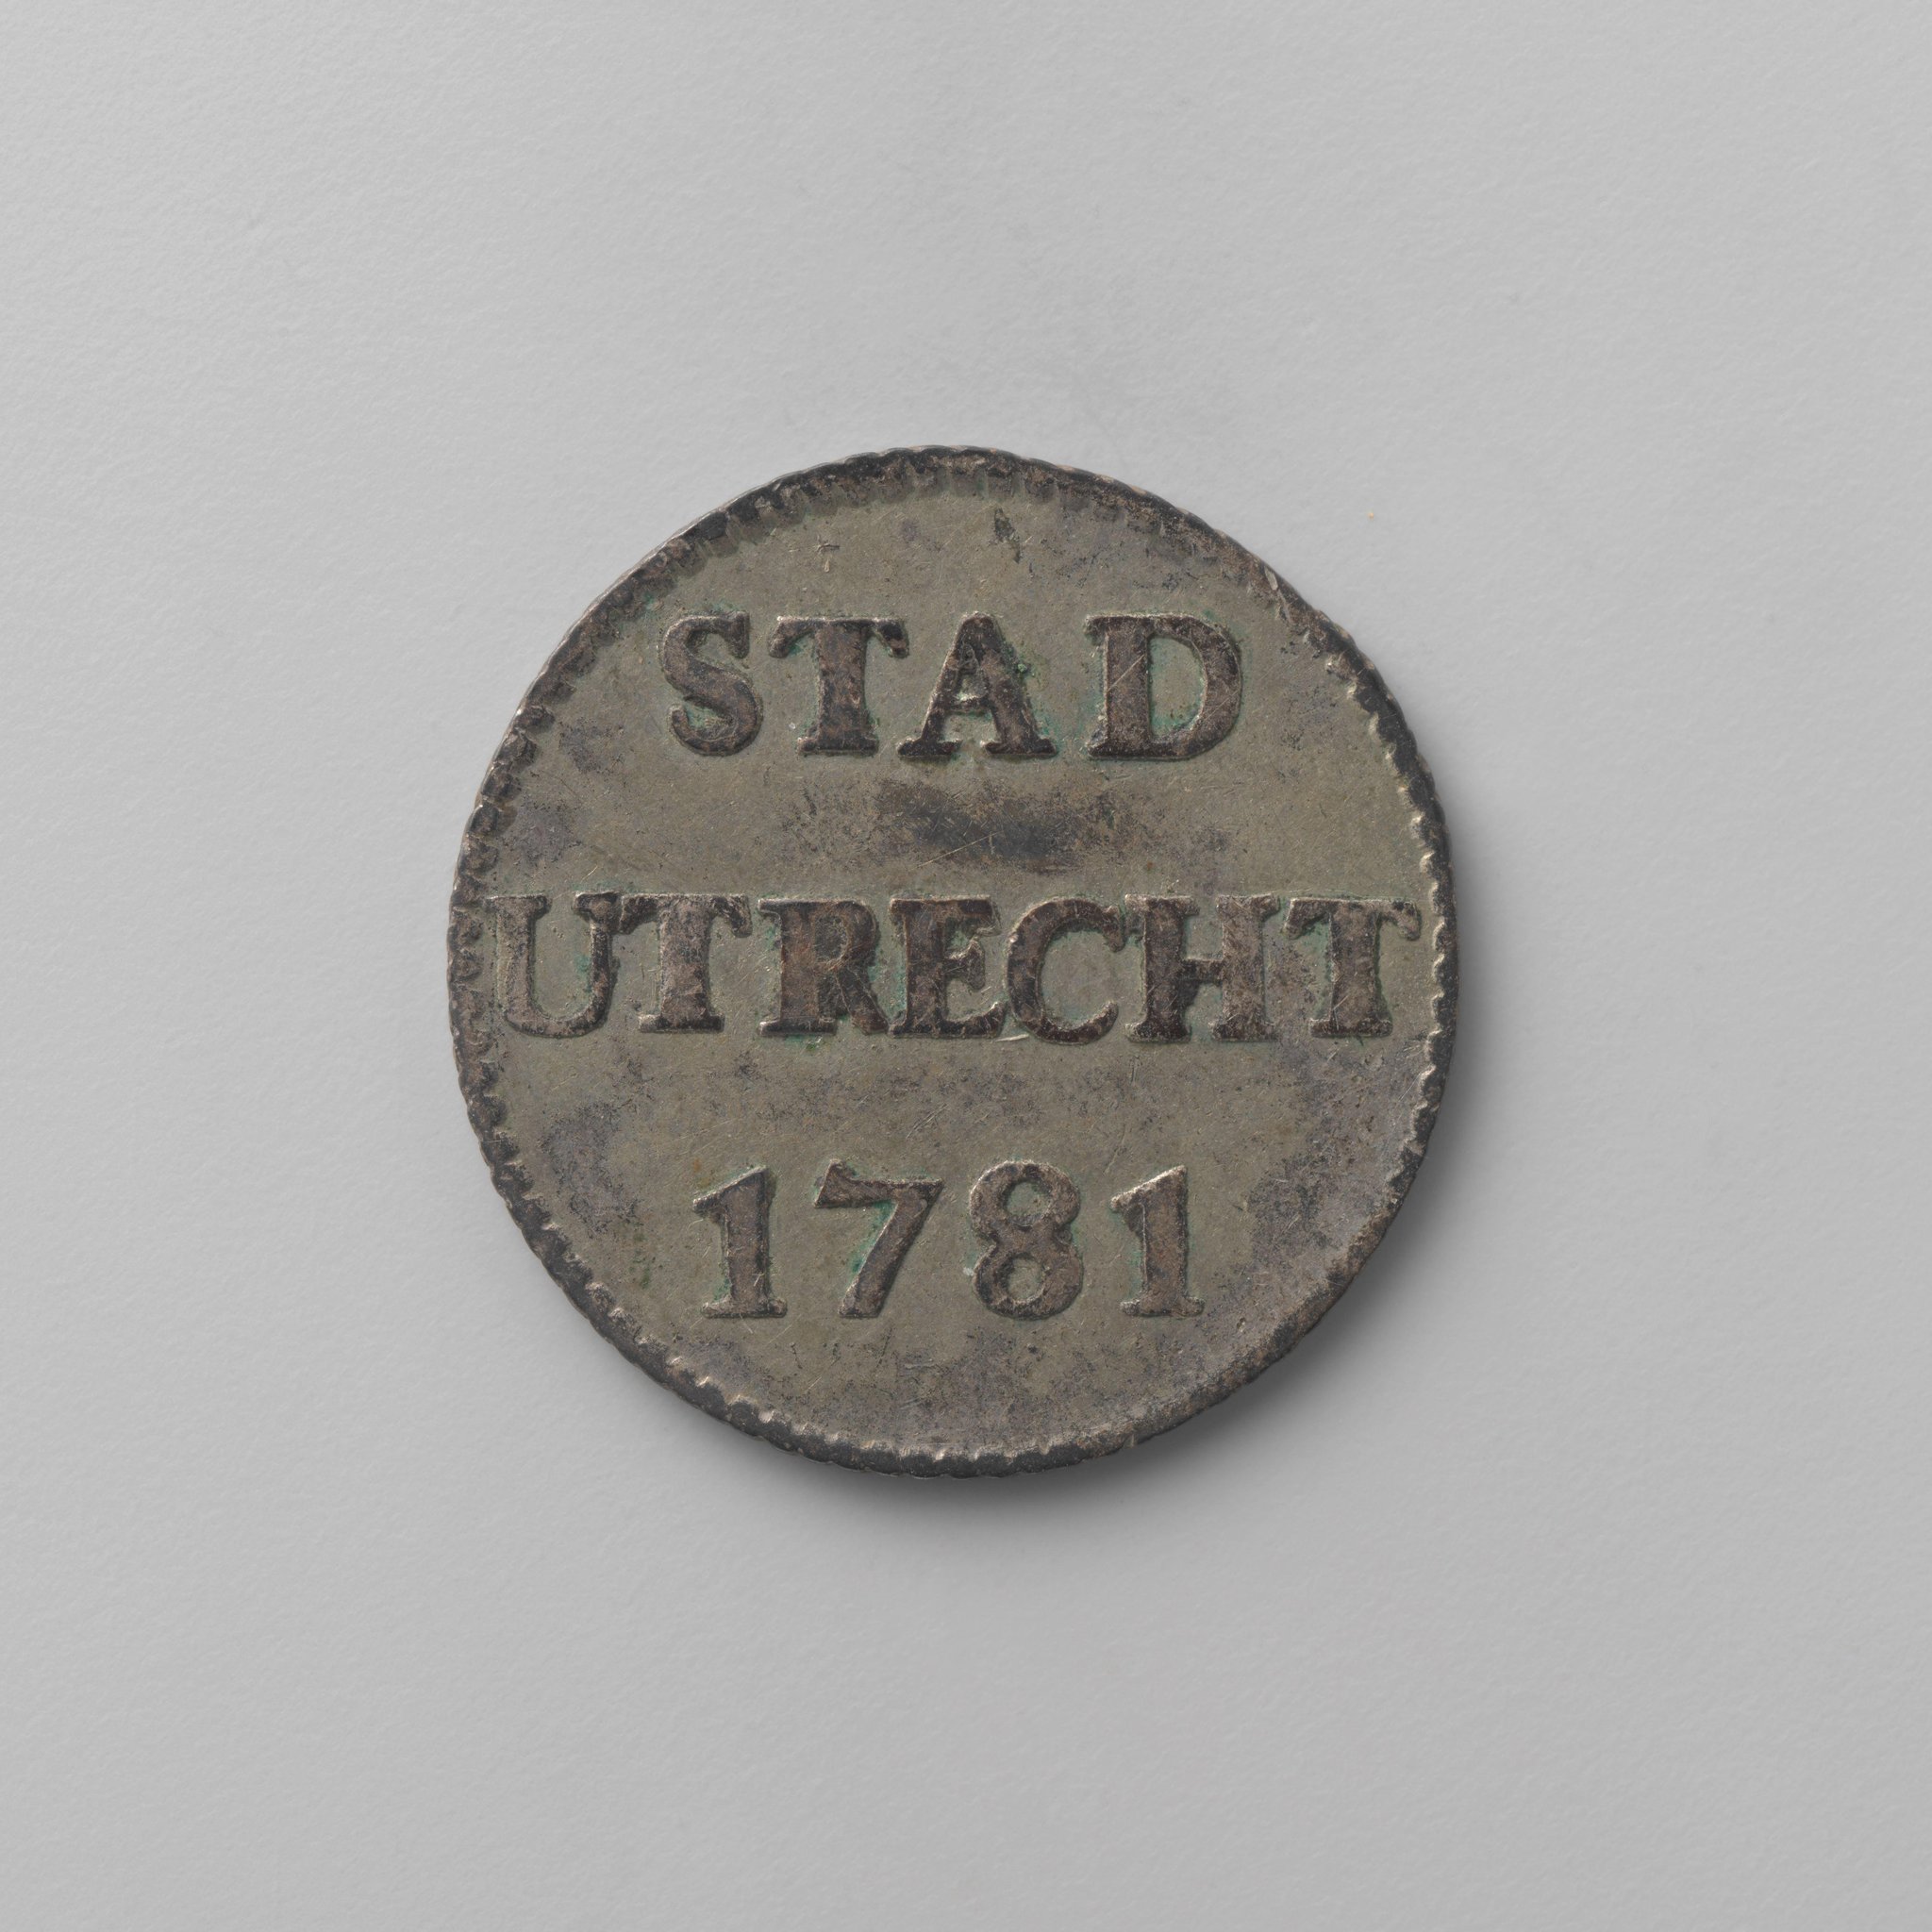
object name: coin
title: Duit van de stad Utrecht, 1781. Afslag in zilver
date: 1781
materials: silver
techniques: striking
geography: utrecht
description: Zilveren munt. Voorzijde: gekroond stedelijk wapenschild, gehouden door twee leeuwen met in afsnede dubbele lijn, waaronder een versierde accolade met een grote schelp. Keerzijde: opschrift in twee regels, waaronder jaartal. Jaartal met Arabische 1. Afslag in zilver. Kabelrand.